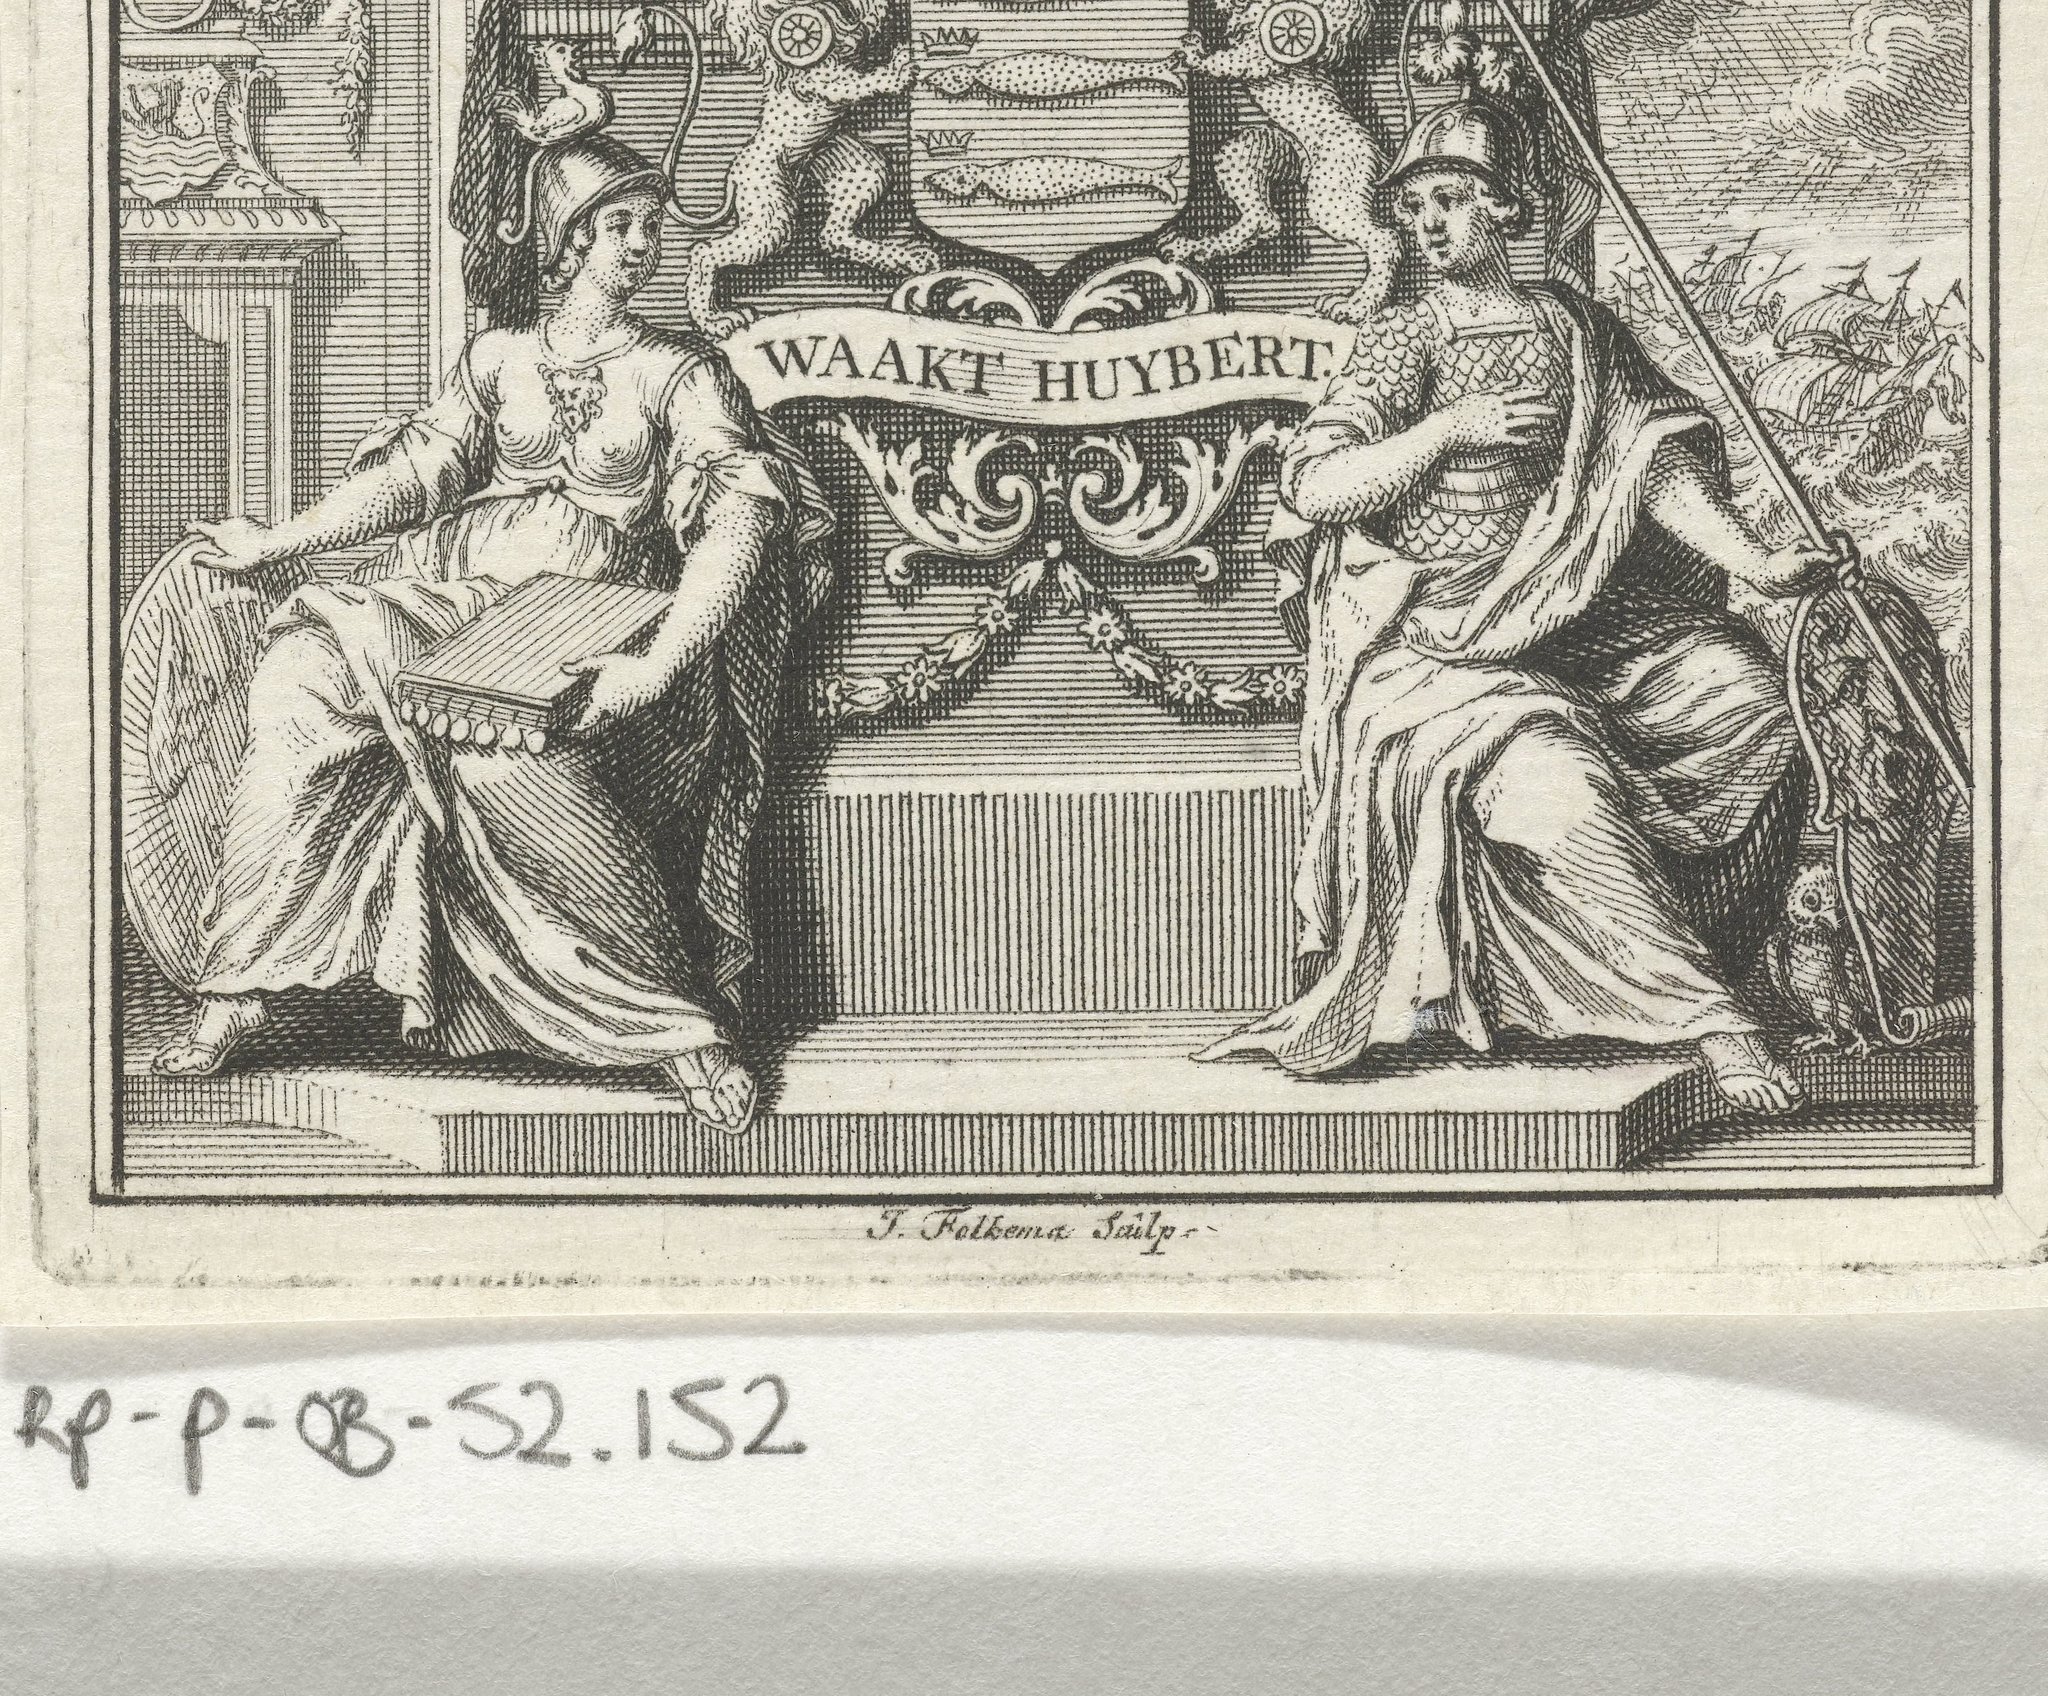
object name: print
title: Wapenschild geflankeerd door allegorische figuren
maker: jacob folkema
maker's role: draughtsman, print maker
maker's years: 1692-1767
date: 1702-1767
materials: paper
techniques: etching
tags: (story of) minerva (pallas, athena), fowl (cock, hen, chicken, etc.) (+ animals used symbolically), holy ghost represented as a dove (in flames) (+ variant), armorial bearing, heraldry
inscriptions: collector's mark: Lugt 240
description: Een gekroond wapenschild met de beeltenis van drie vissen wordt geflankeerd door Minerva en een allegorische figuur met een boek op schoot. Haar helm is getooid met een haan, symbool van de waaksheid, en haar hand rust op een schild waarop een duif staat afgebeeld, het christelijke symbool voor de Heilige Geest. Onder het wapen staat op een banderol de tekst: Waakt Huybert.